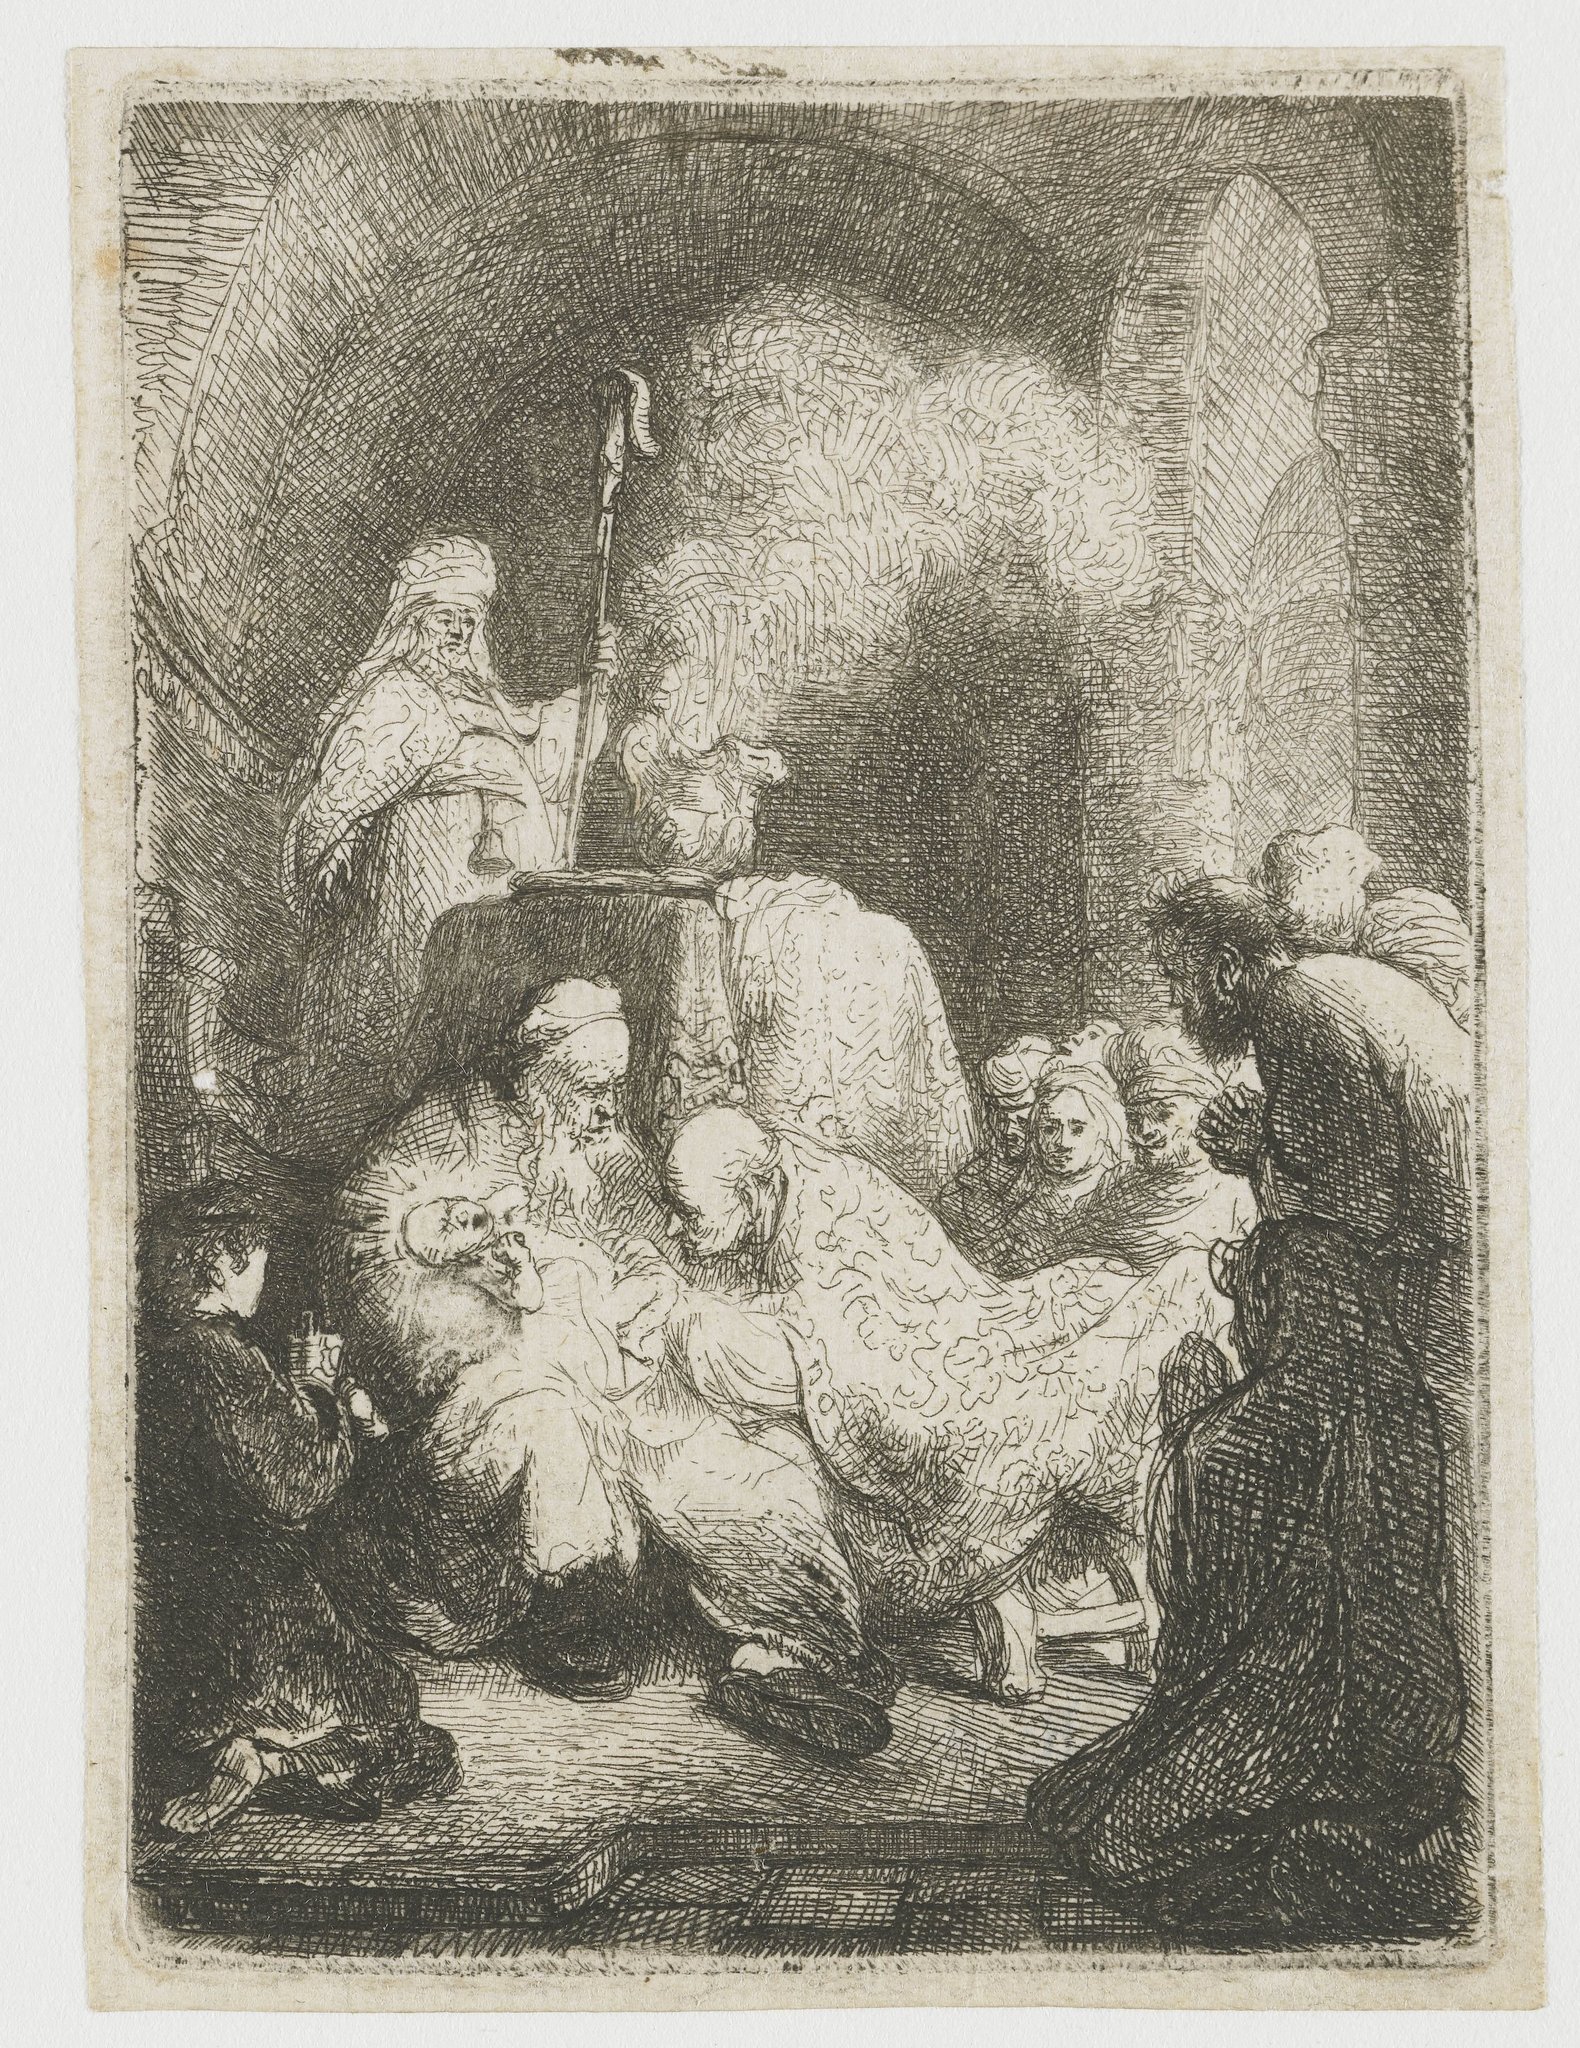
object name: print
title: The circumcision: small plate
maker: rembrandt van rijn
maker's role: draughtsman, painter, print maker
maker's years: 1606-1669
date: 1630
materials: paper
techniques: drypoint, etching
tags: circumcision of the christ-child by the priest in the temple (luke 2:21)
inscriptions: mark: Lugt 2228